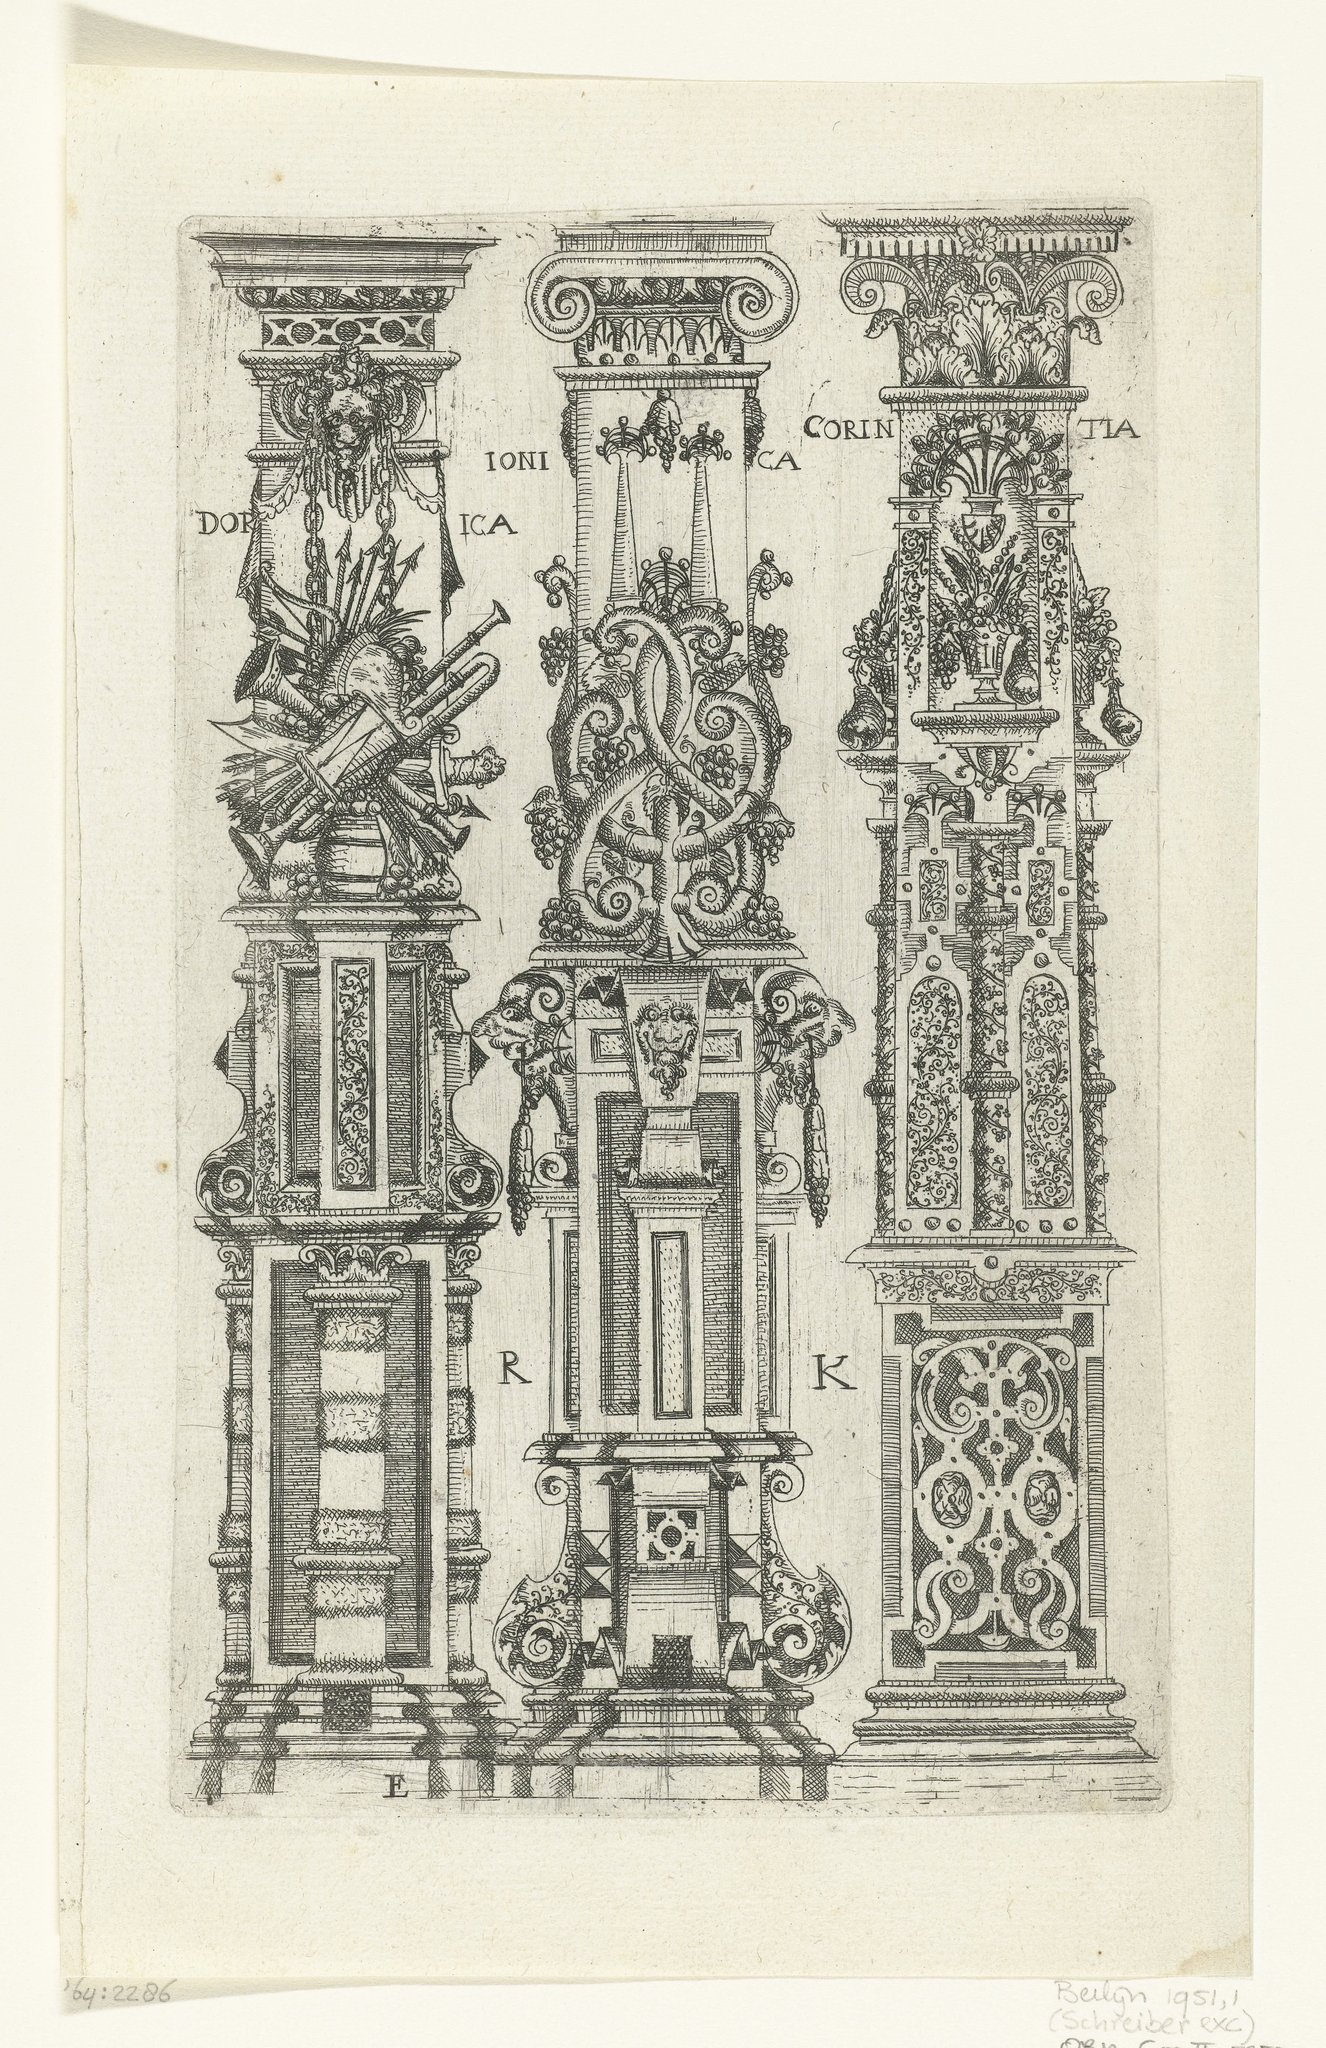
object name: ornament print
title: Livre d' Architecture contenant plusieurs beaux ornementz (...)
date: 1622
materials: paper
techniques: etching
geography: paris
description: Zuilen van de Dorische, Ionische en Korintische orde, met fantasiedecoratie. Op de linkerzuil staat een wapentrofee. Blad E uit tweede editie van serie, bestaande uit 24 bladen.